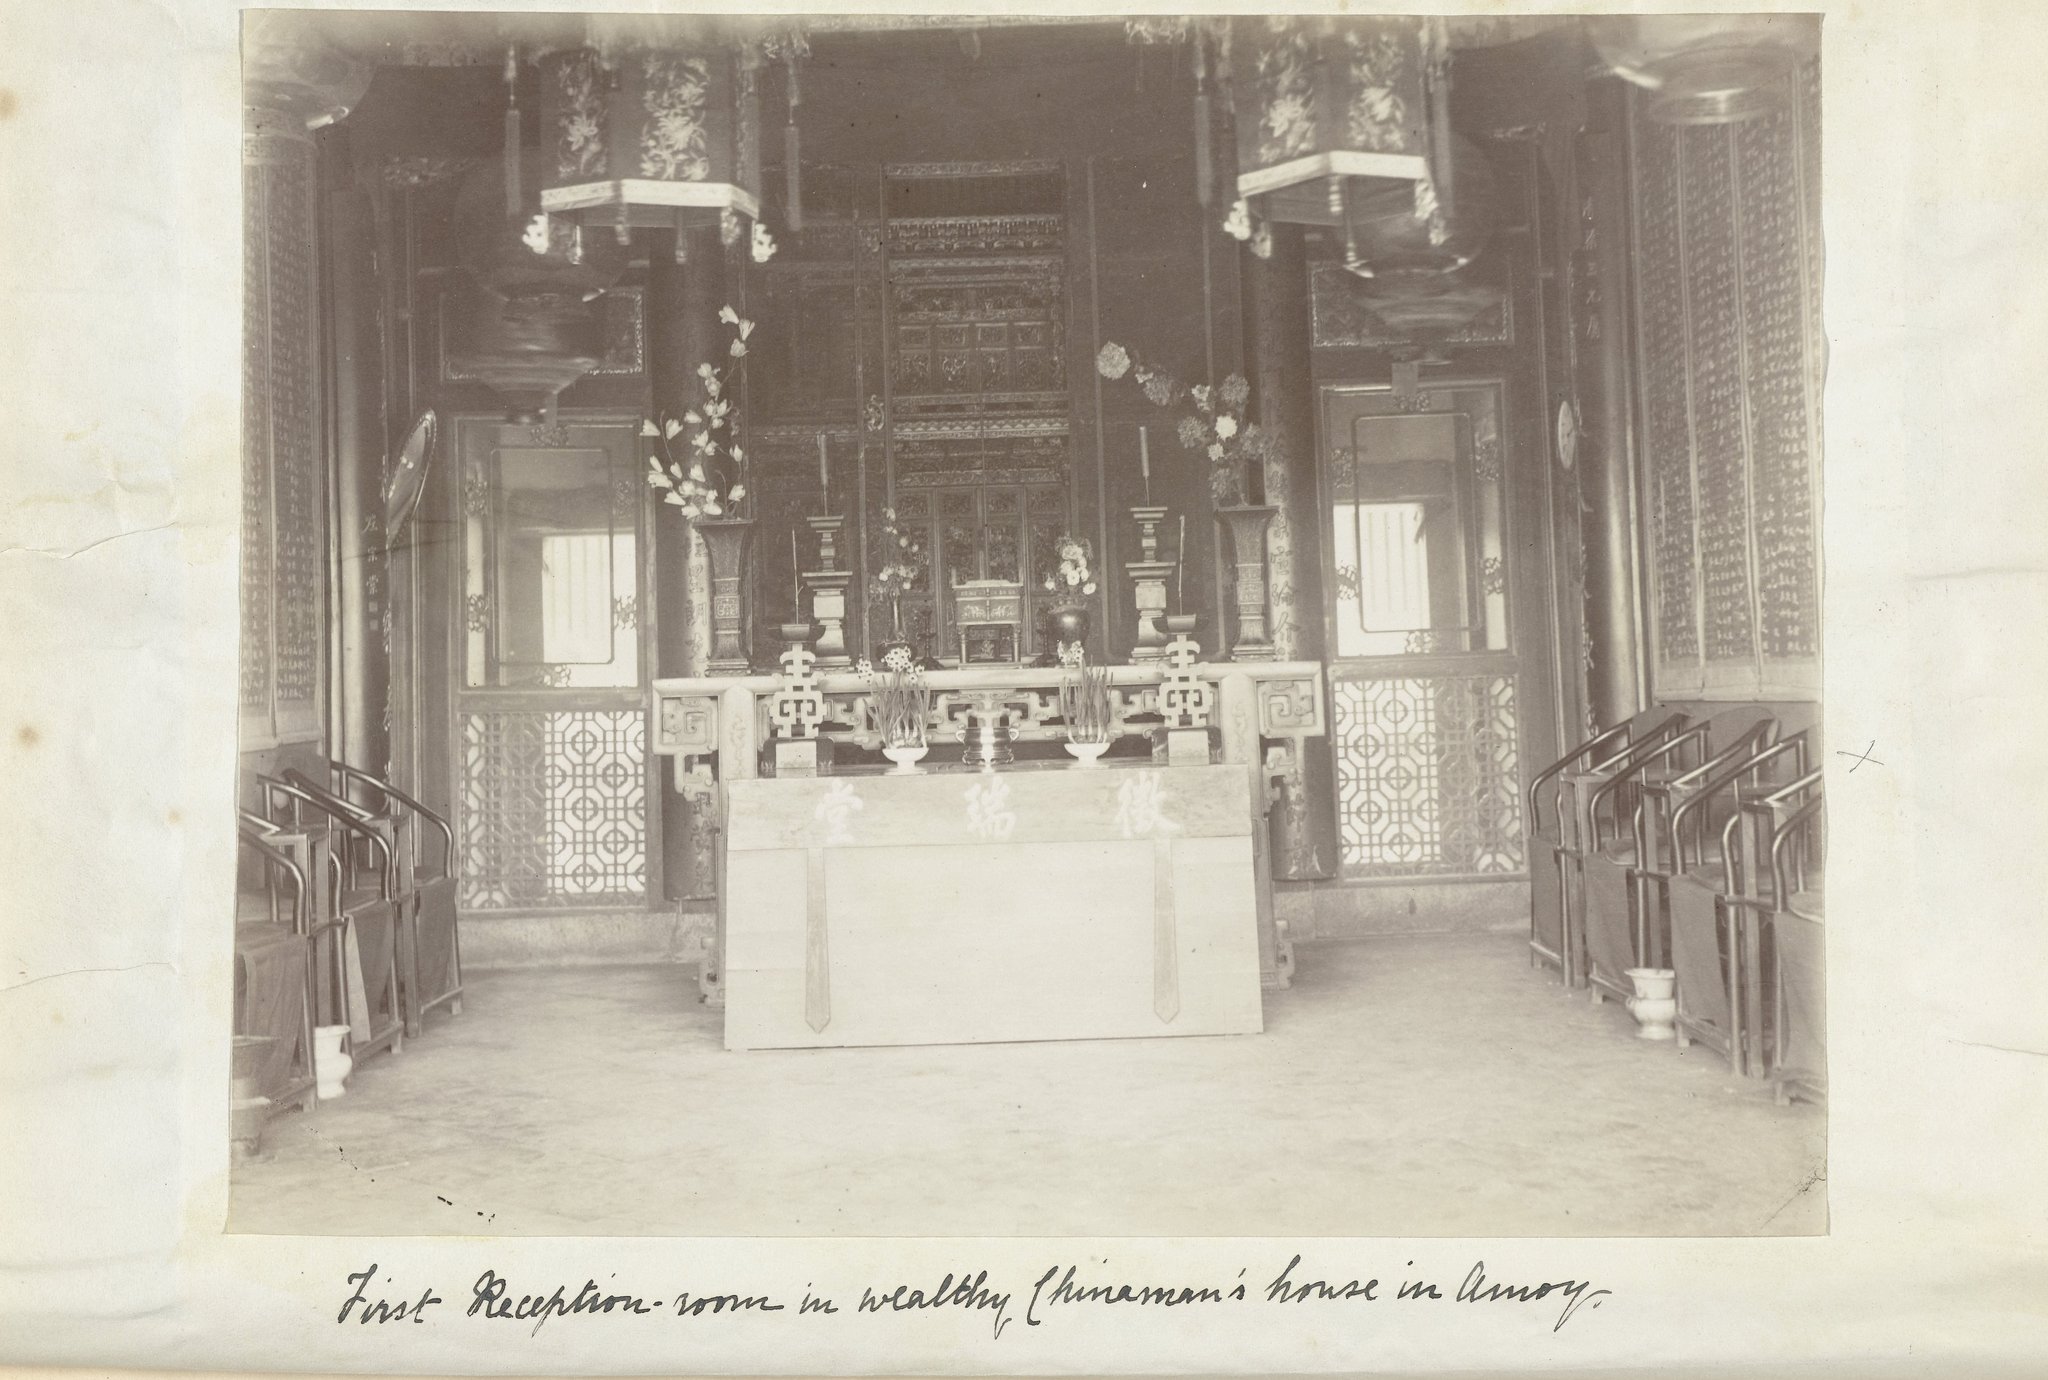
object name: album leaf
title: First Reception-room in wealthy Chinaman's house in Amoy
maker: Anonymous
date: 1879-1890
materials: paper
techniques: albumen print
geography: xiamen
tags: interior of the house